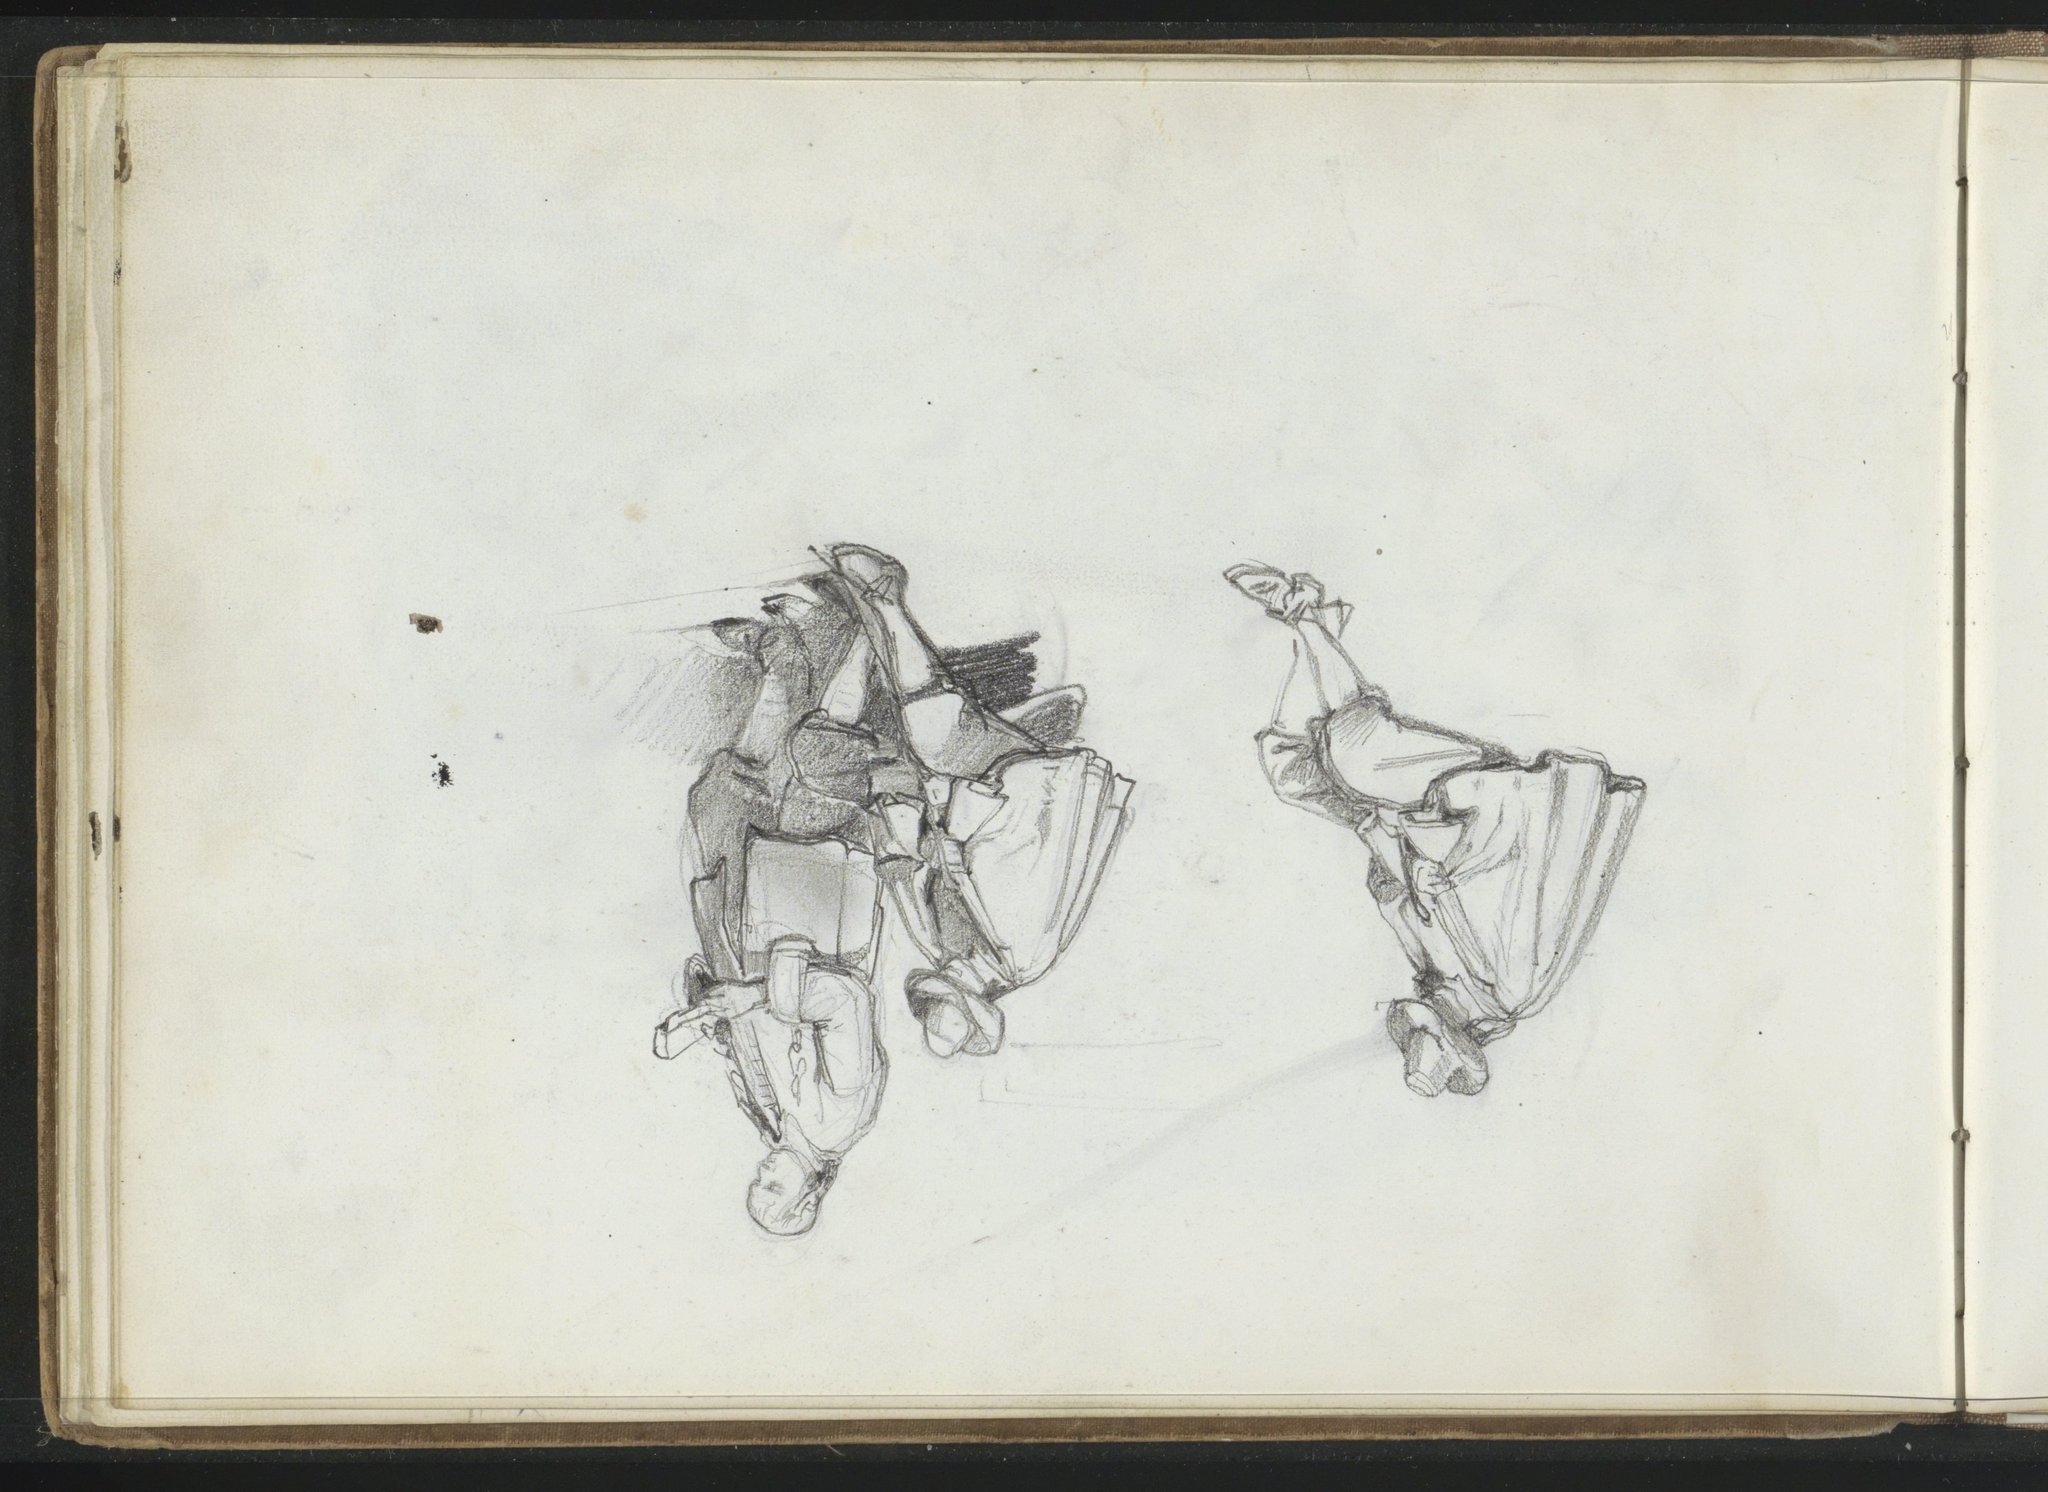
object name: sketchbook leaf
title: Zittende mannen en een staande man in zeventiende-eeuws kostuum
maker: johannes bosboom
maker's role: draughtsman, painter, print maker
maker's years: 1817-1891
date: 1827-1891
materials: paper, pencil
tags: standing figure (+ male human being (not to be used where -a- is prescribed)), sitting figure (+ male human being (not to be used where -a- is prescribed)), historical costume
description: Blad 20 verso uit een schetsboek met 41 pagina's.